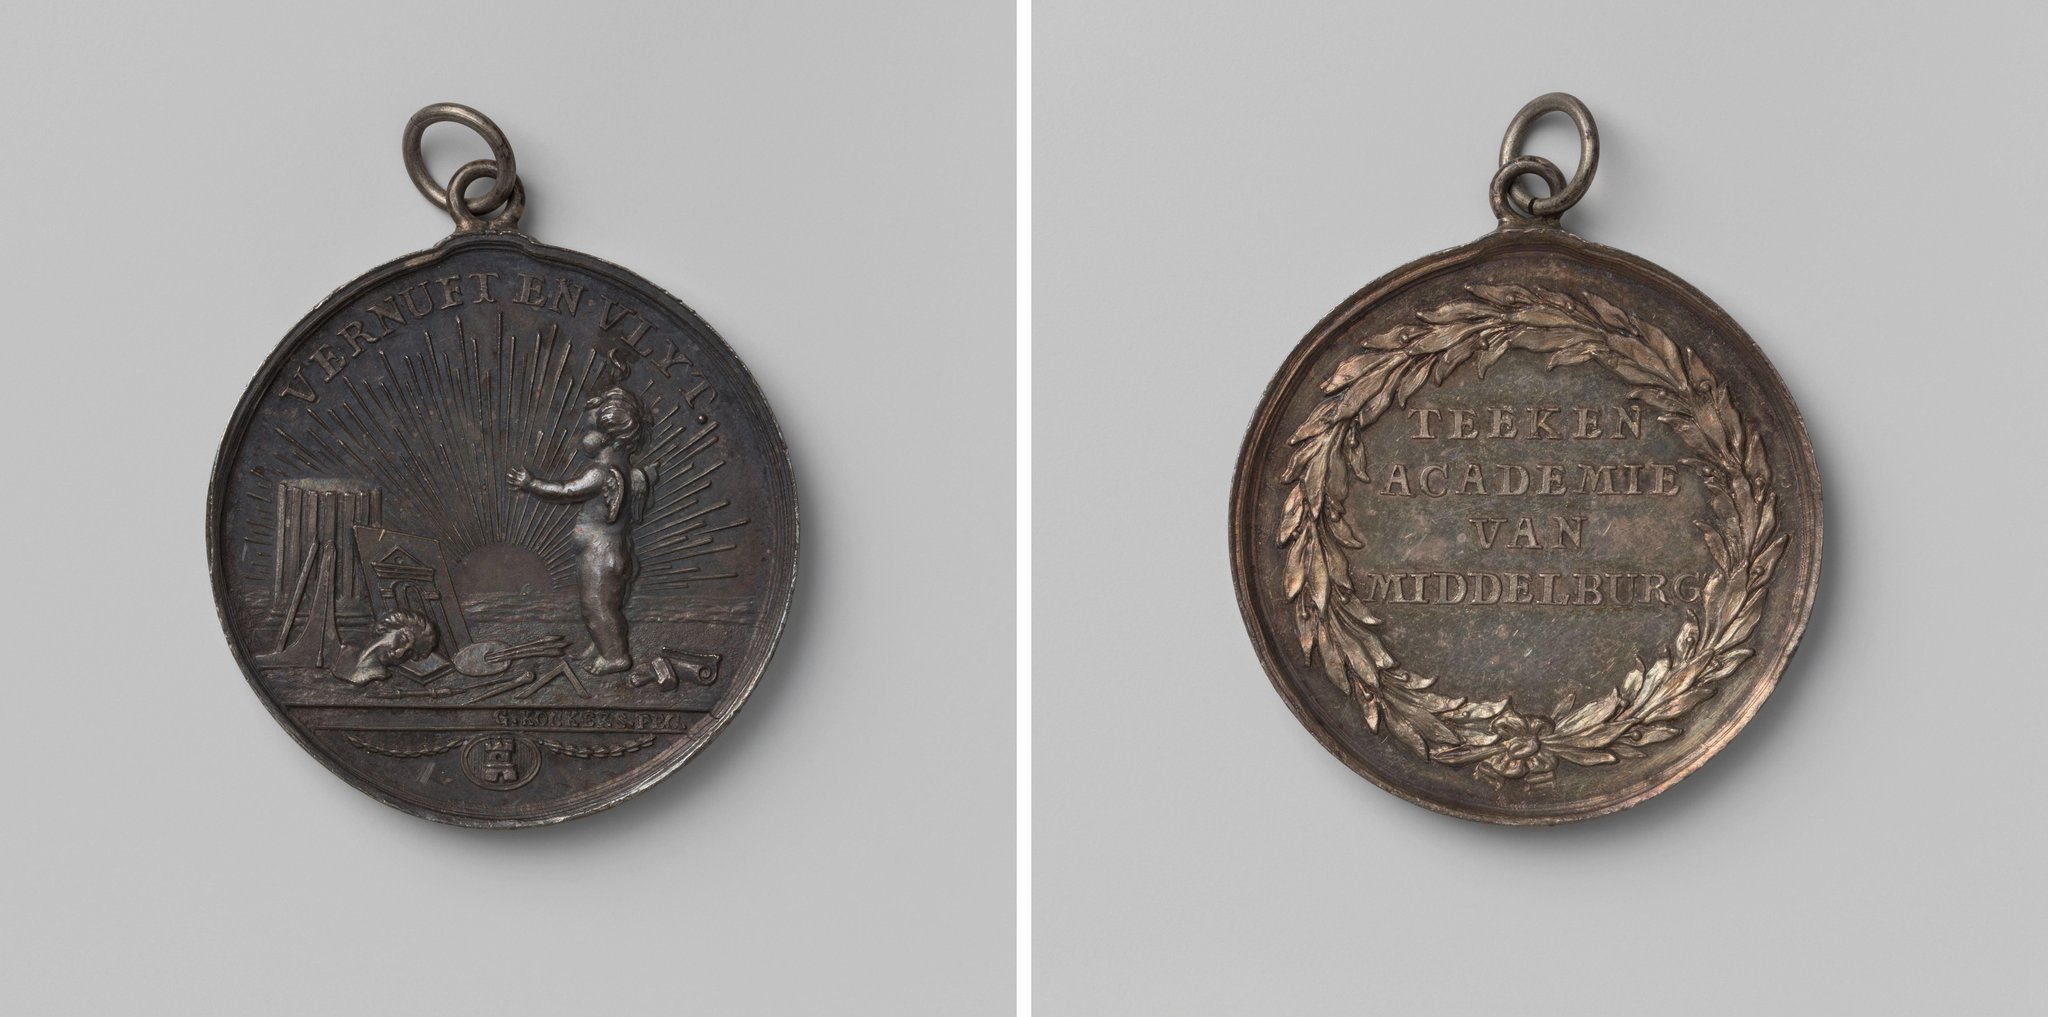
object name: medal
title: Tekenakademie te Middelburg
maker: george kockers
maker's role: goldsmith, print maker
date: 1779-1790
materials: silver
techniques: striking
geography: middelburg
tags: middelburg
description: Zilveren penning aan draagoog en draagring. Voorzijde: genius, staande voor voorwerpen en gereedschap van bouw-, schilder-, teken- en meetkunst verzameld rond afgebroken zuil, kijkt naar opkomende zon binnen omschrift; afsnede: wapenschild. Keerzijde: opschrift binnen lauwerkrans.